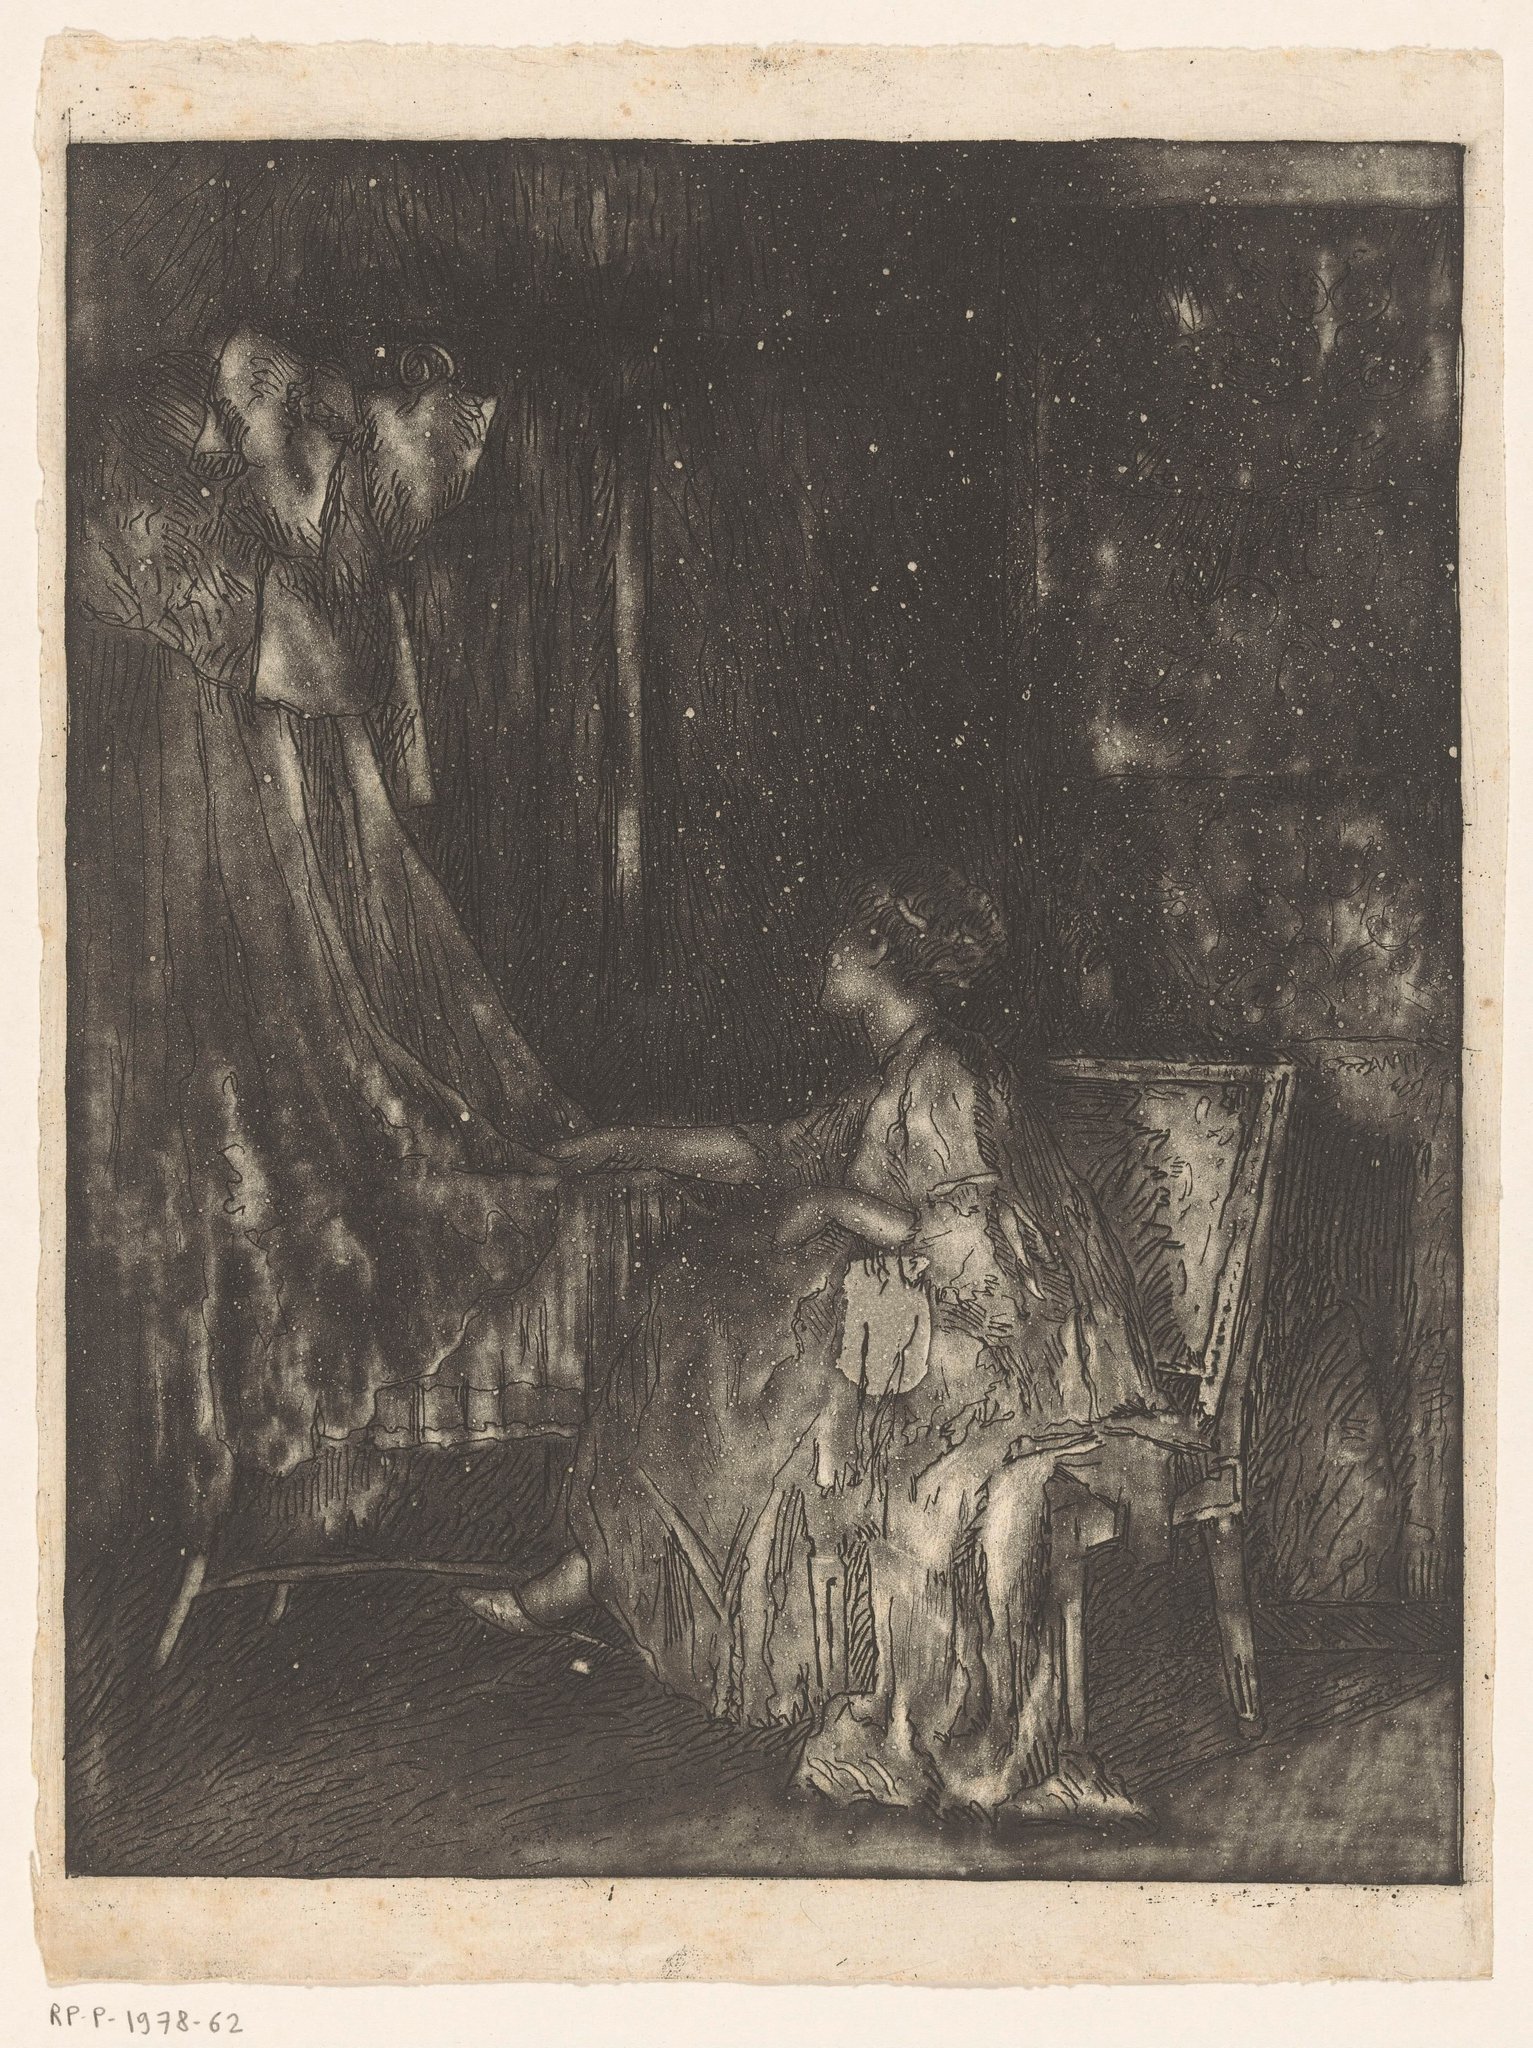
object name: print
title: Vrouw die op een stoel naast een wieg zit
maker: albert roelofs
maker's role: print maker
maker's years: 1877-1920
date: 1887-1920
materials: paper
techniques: aquatint, etching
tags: cradle, crib, mother and child(ren), woman and child(ren) (family group)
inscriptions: collector's mark: Lugt 2760, collector's mark: Lugt 2228, number: ‘1219 / 21’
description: De vrouw leunt met haar arm op de rand van de wieg.